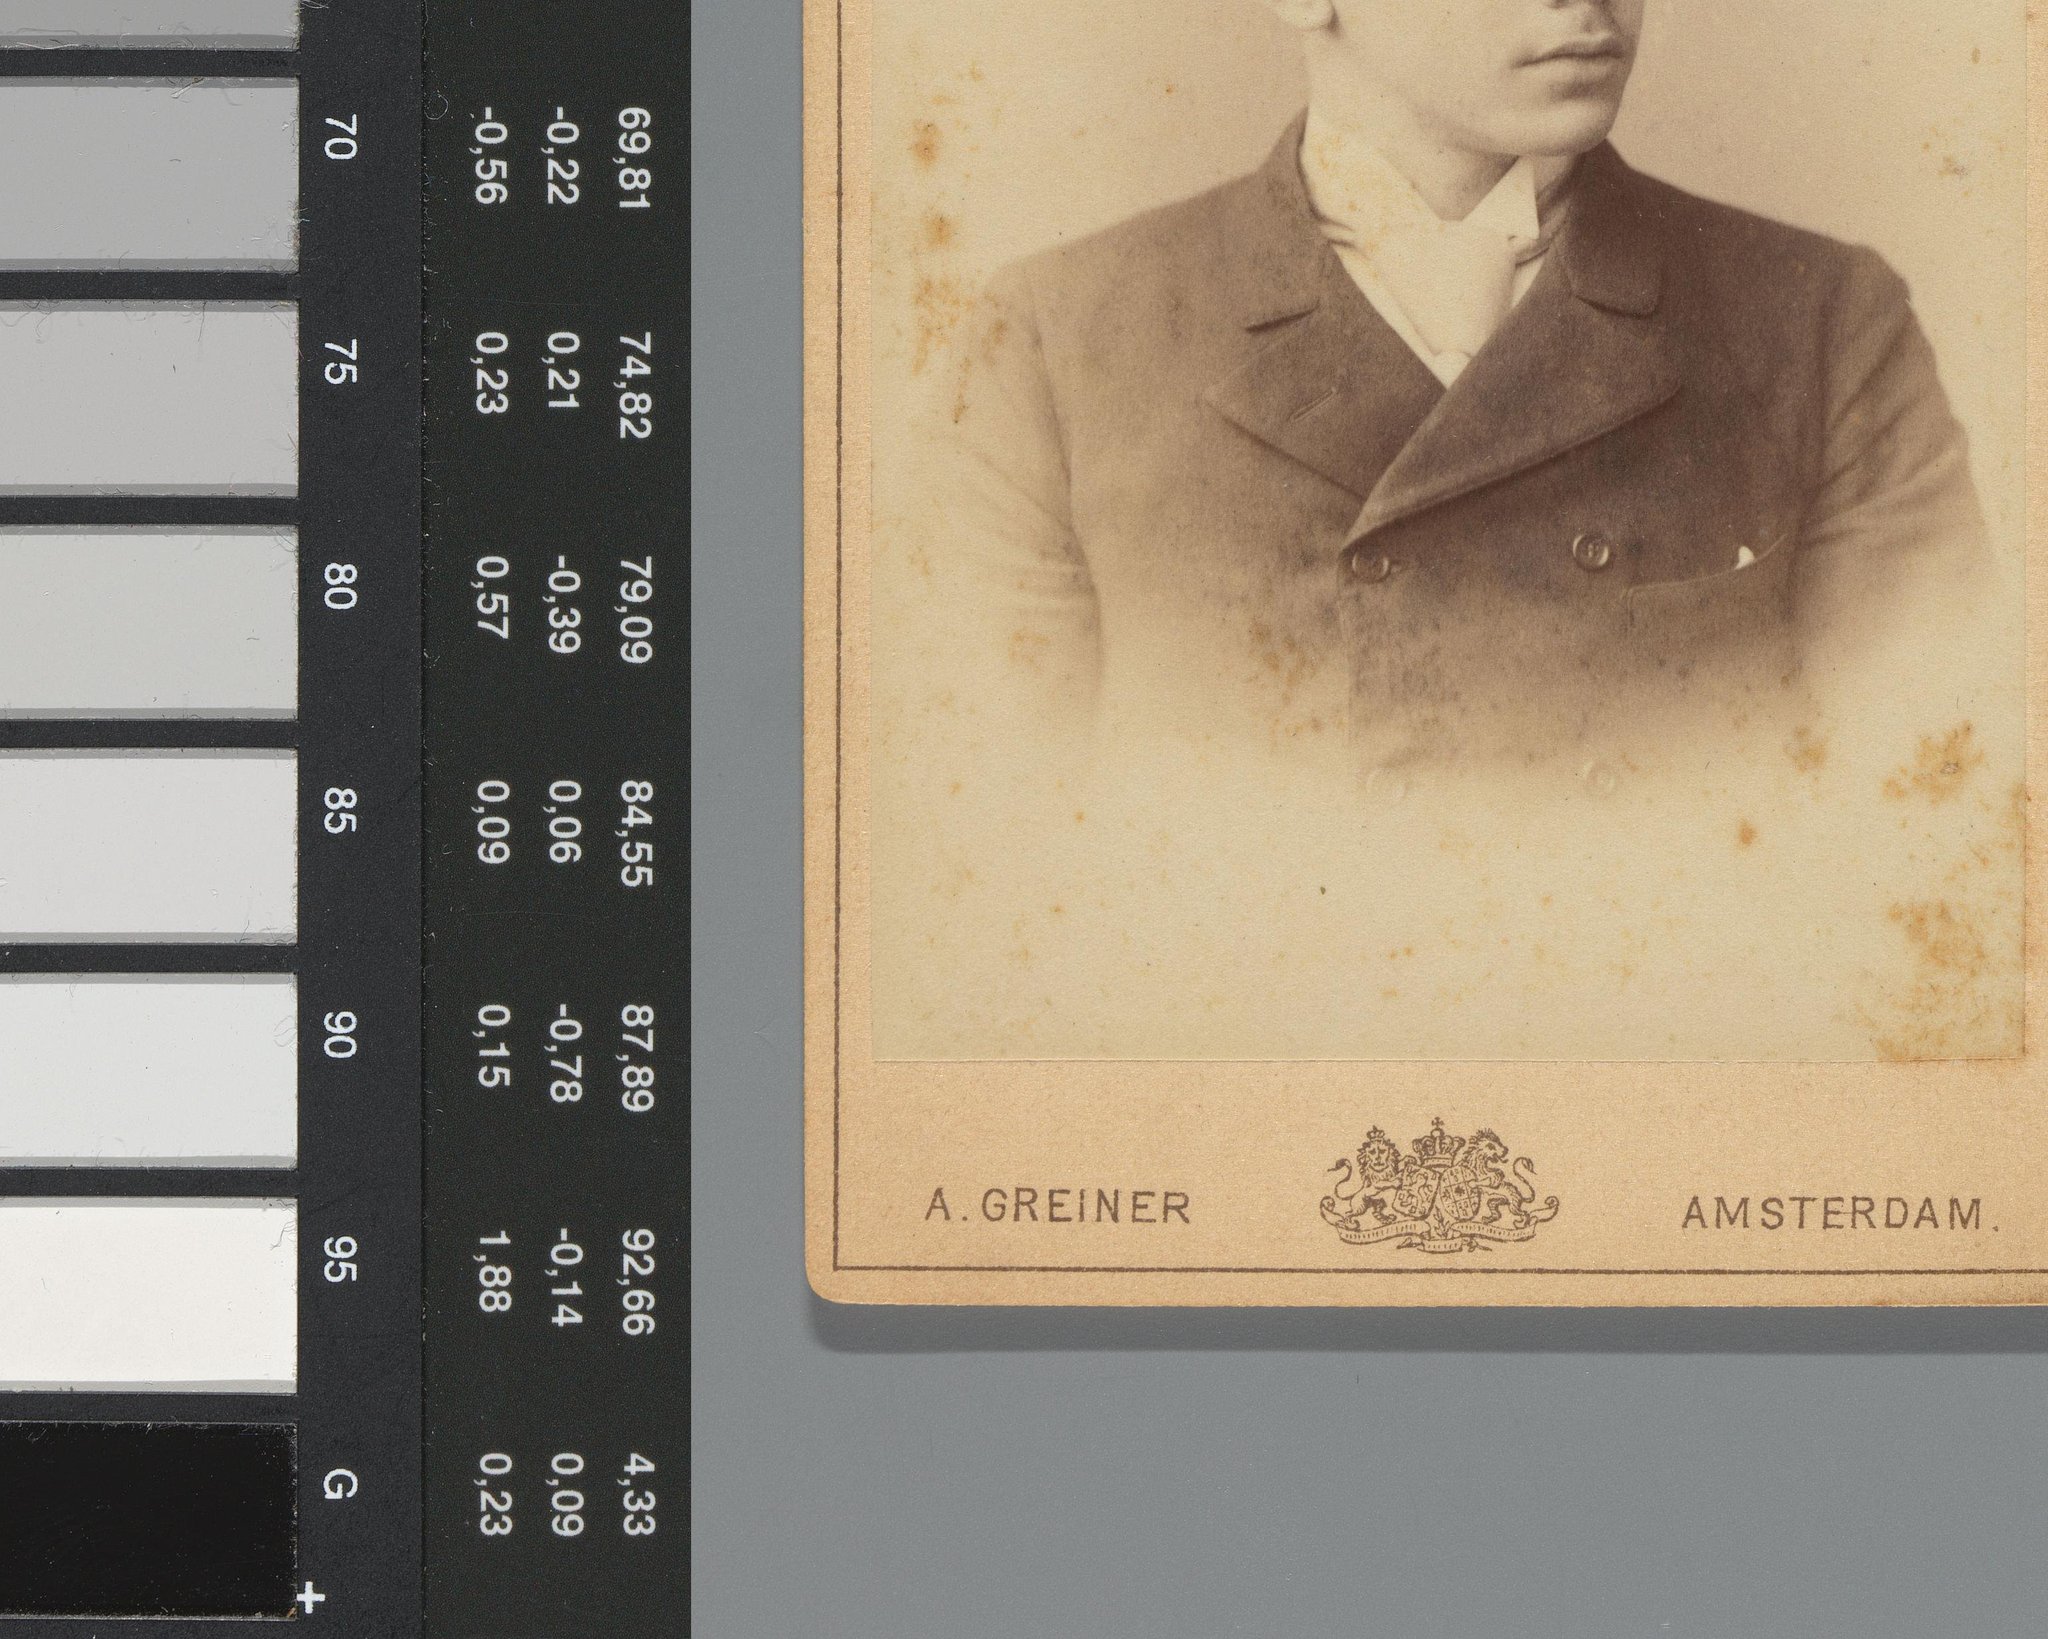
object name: carte de visite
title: Portret van Hendrik Herman van den Berg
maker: albert greiner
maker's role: fotograaf, fotostudio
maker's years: 1833-1890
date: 1885-1890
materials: cardboard, photographic support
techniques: albumen print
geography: amsterdam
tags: batavia, hendrik herman van den berg, amsterdam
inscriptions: inscription: ‘H.H. van den Berg’, name: ‘ALBERT GREINER / KON. NED. HOF-PHOTOGRAAF / AMSTERDAM / NIEUWENDIJK 89. / Specialiteit in Vergrootingen’, name: ‘A. GREINER AMSTERDAM’